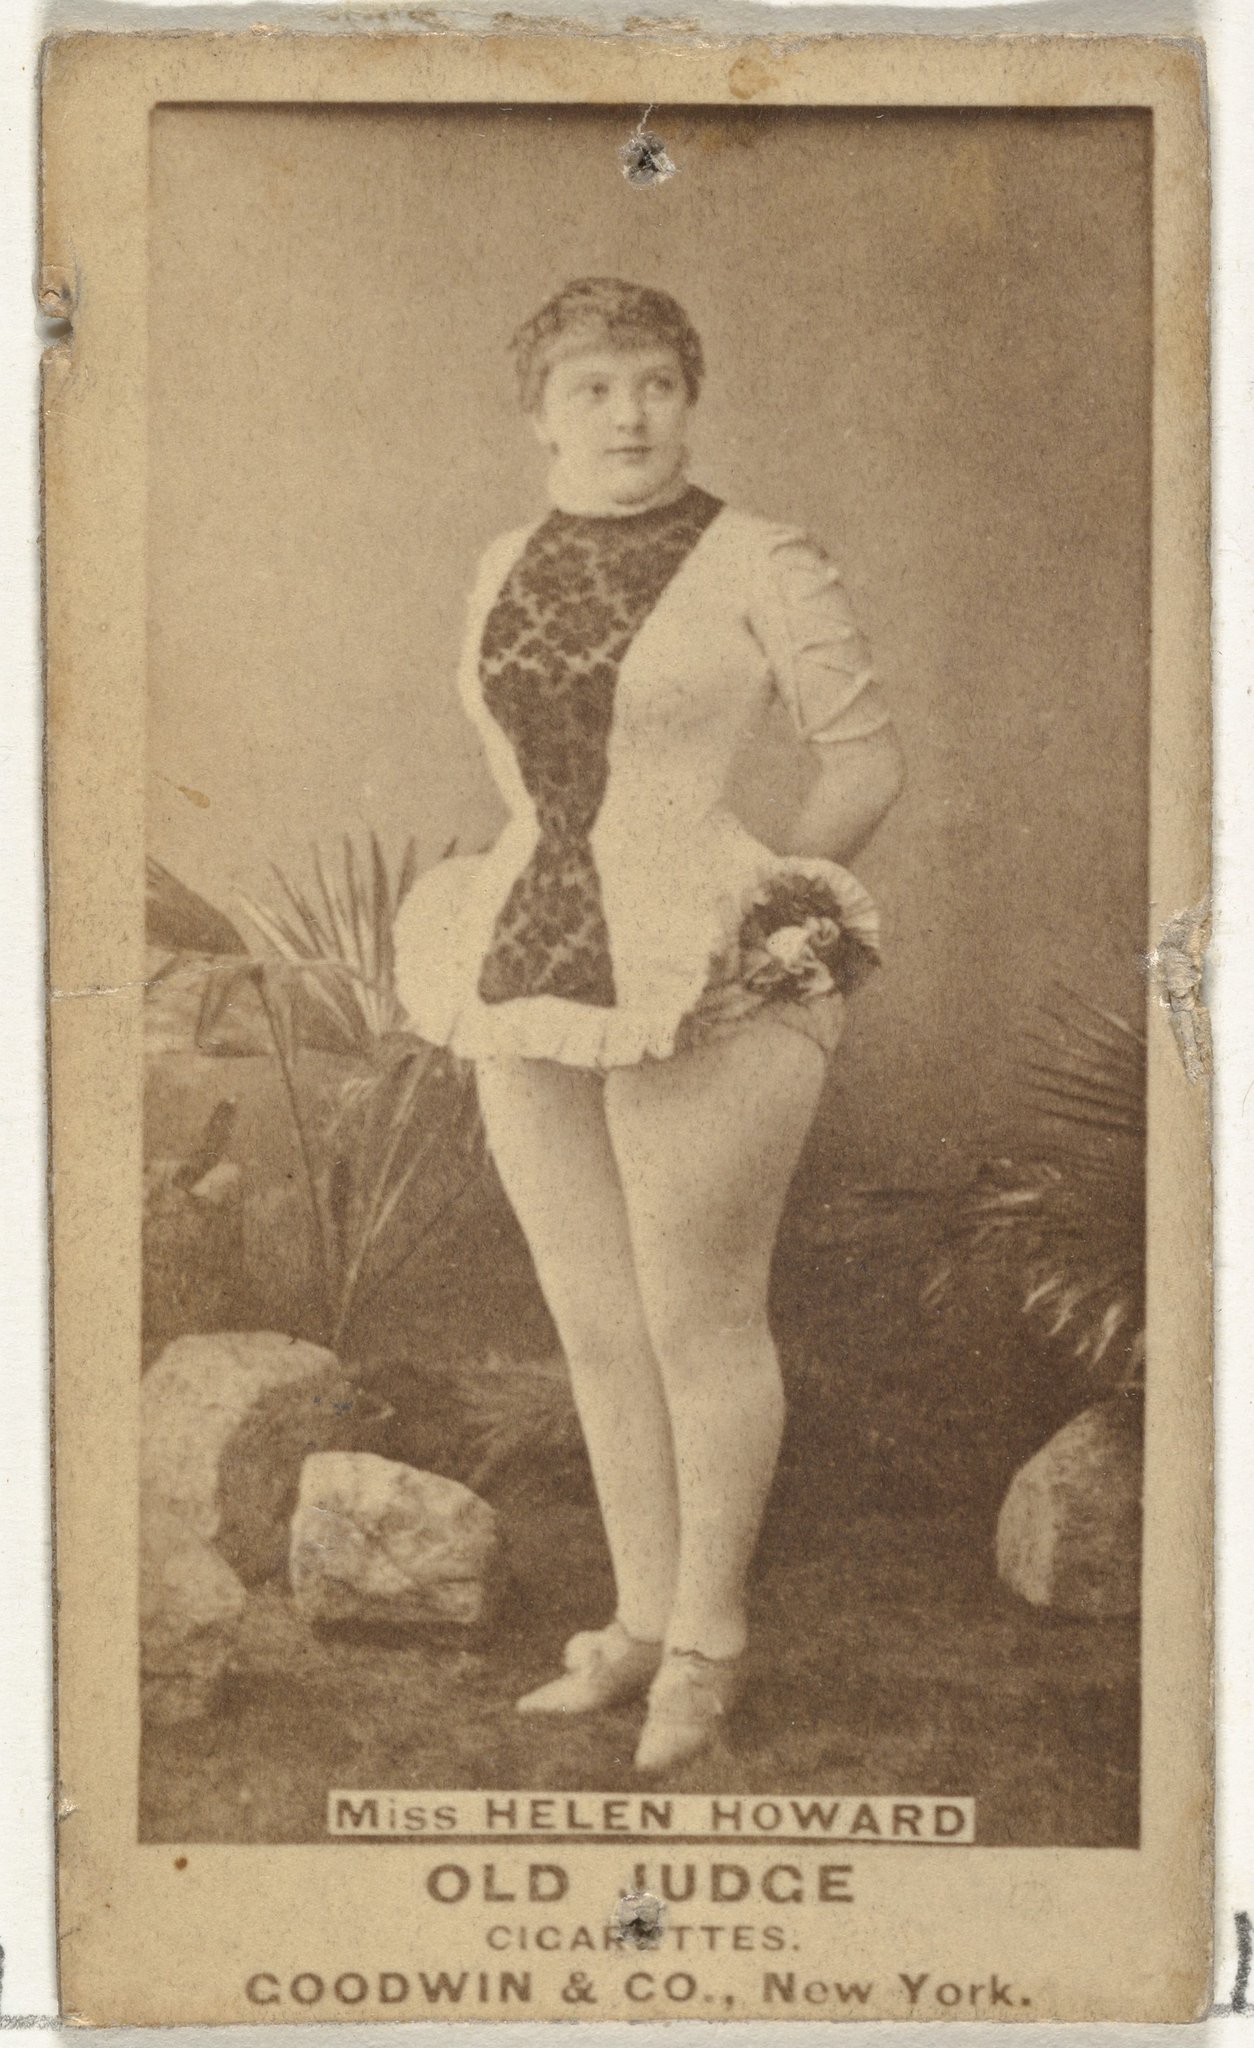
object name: photograph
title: Miss Helen Howard, from the Actors and Actresses series (N171) for Old Judge Cigarettes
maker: goodwin & company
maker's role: publisher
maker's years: 1850-1950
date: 1886-1890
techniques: albumen silver print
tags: portraits,women,actresses